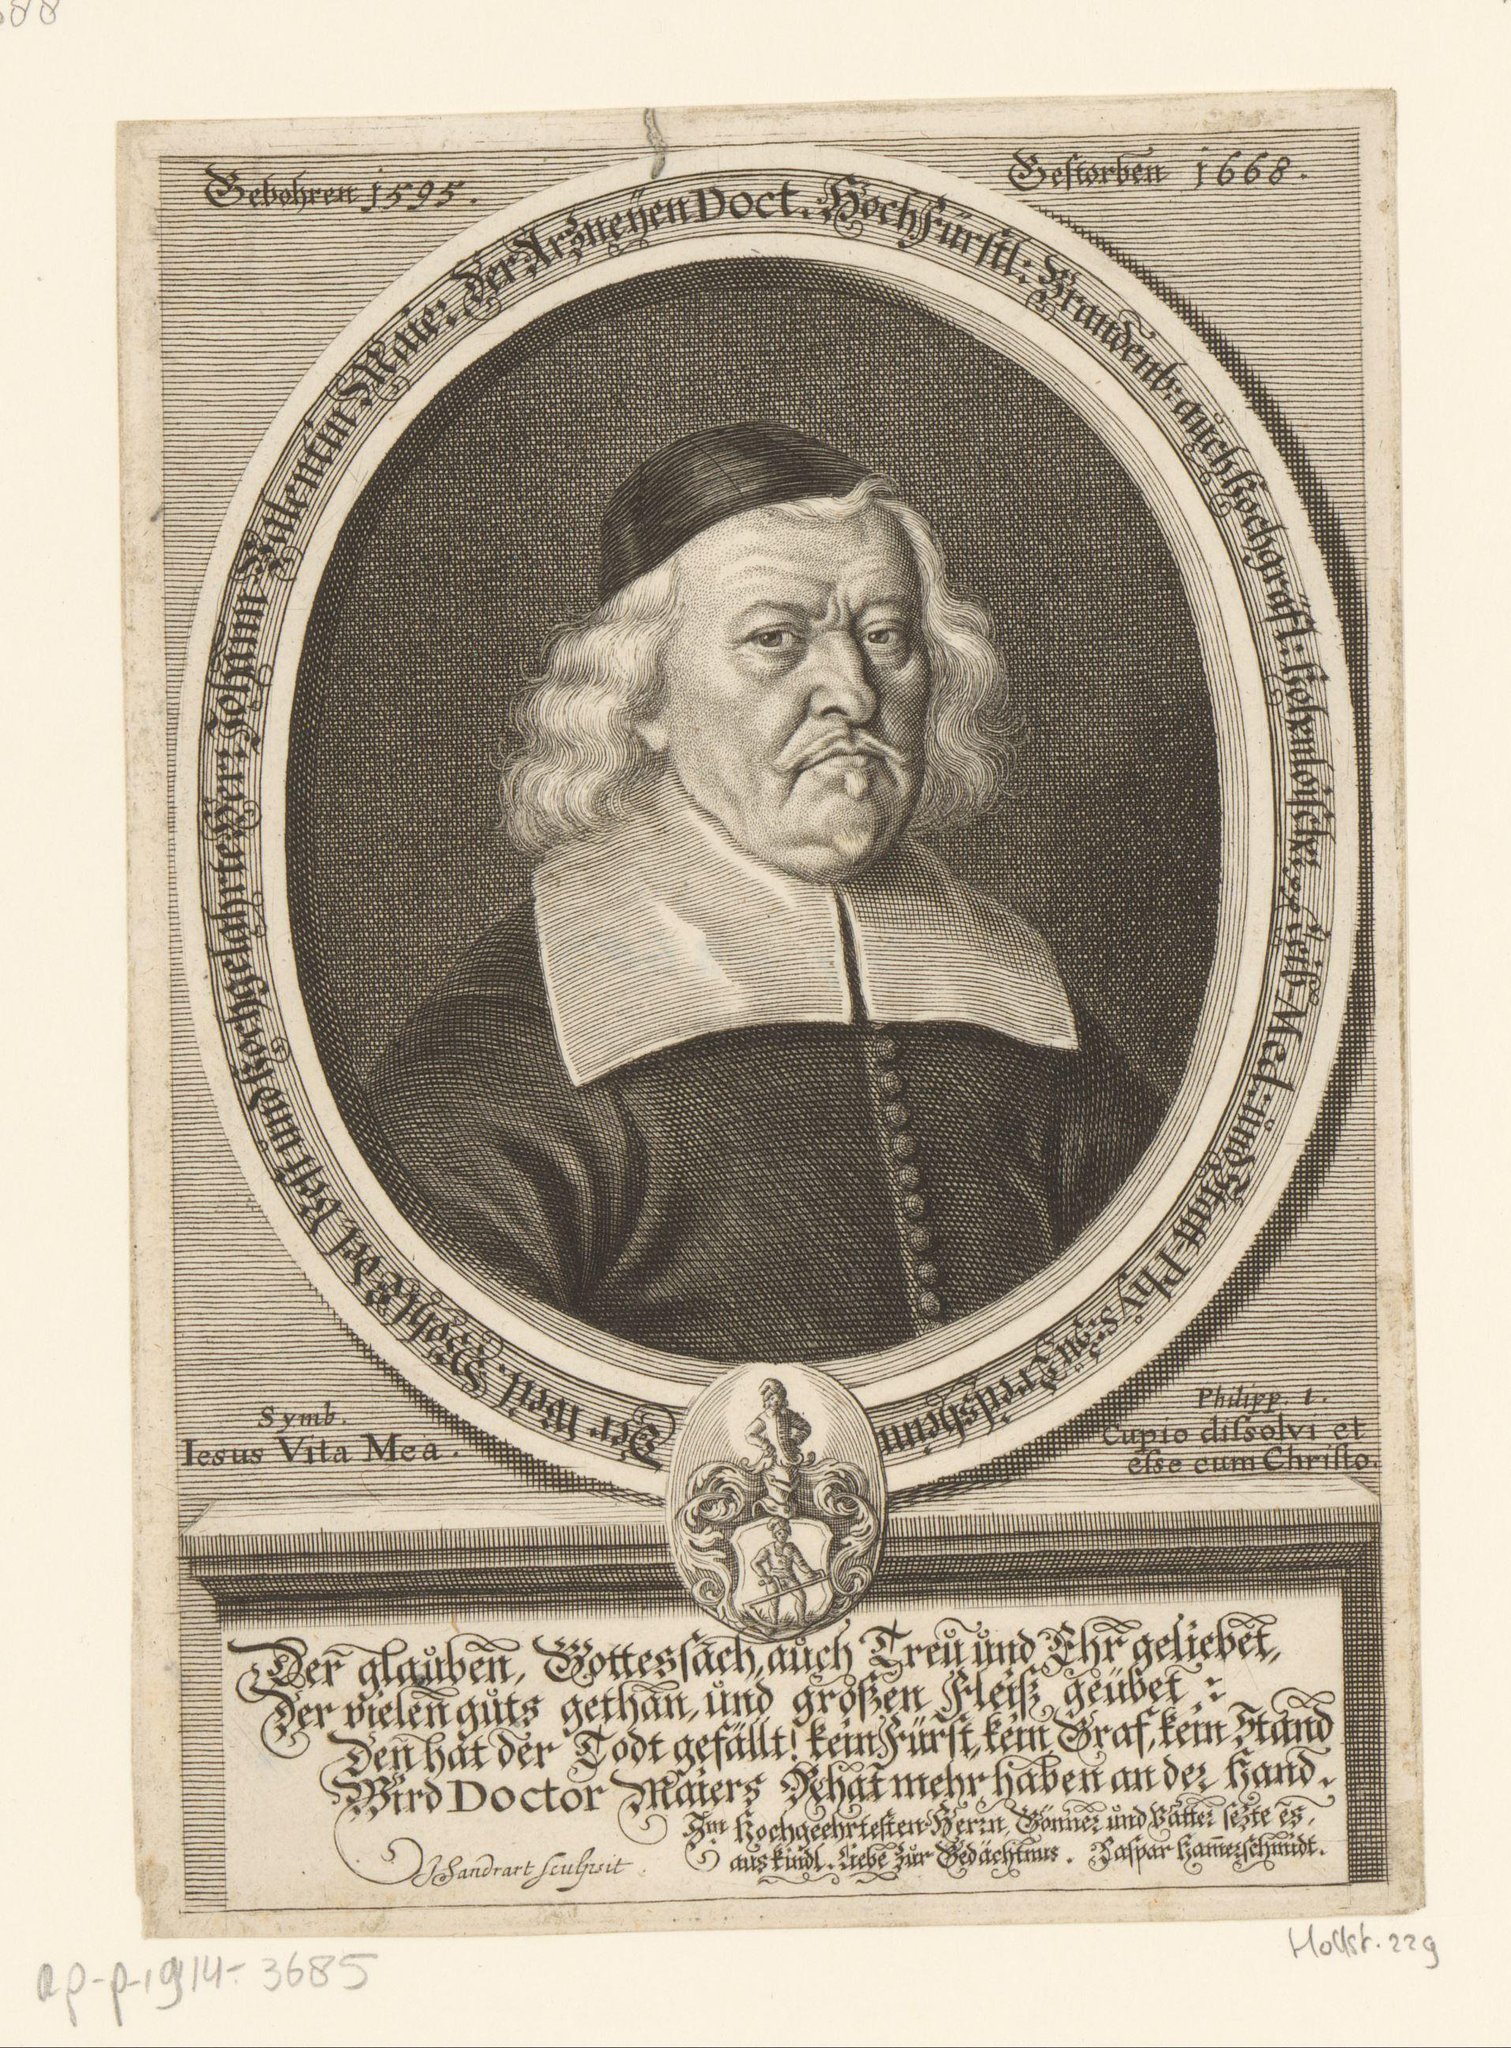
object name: print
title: Portret van Johann Valentin Maier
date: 1668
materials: paper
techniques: engraving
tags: historical persons, armorial bearing, heraldry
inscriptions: collector's mark: Lugt 2228